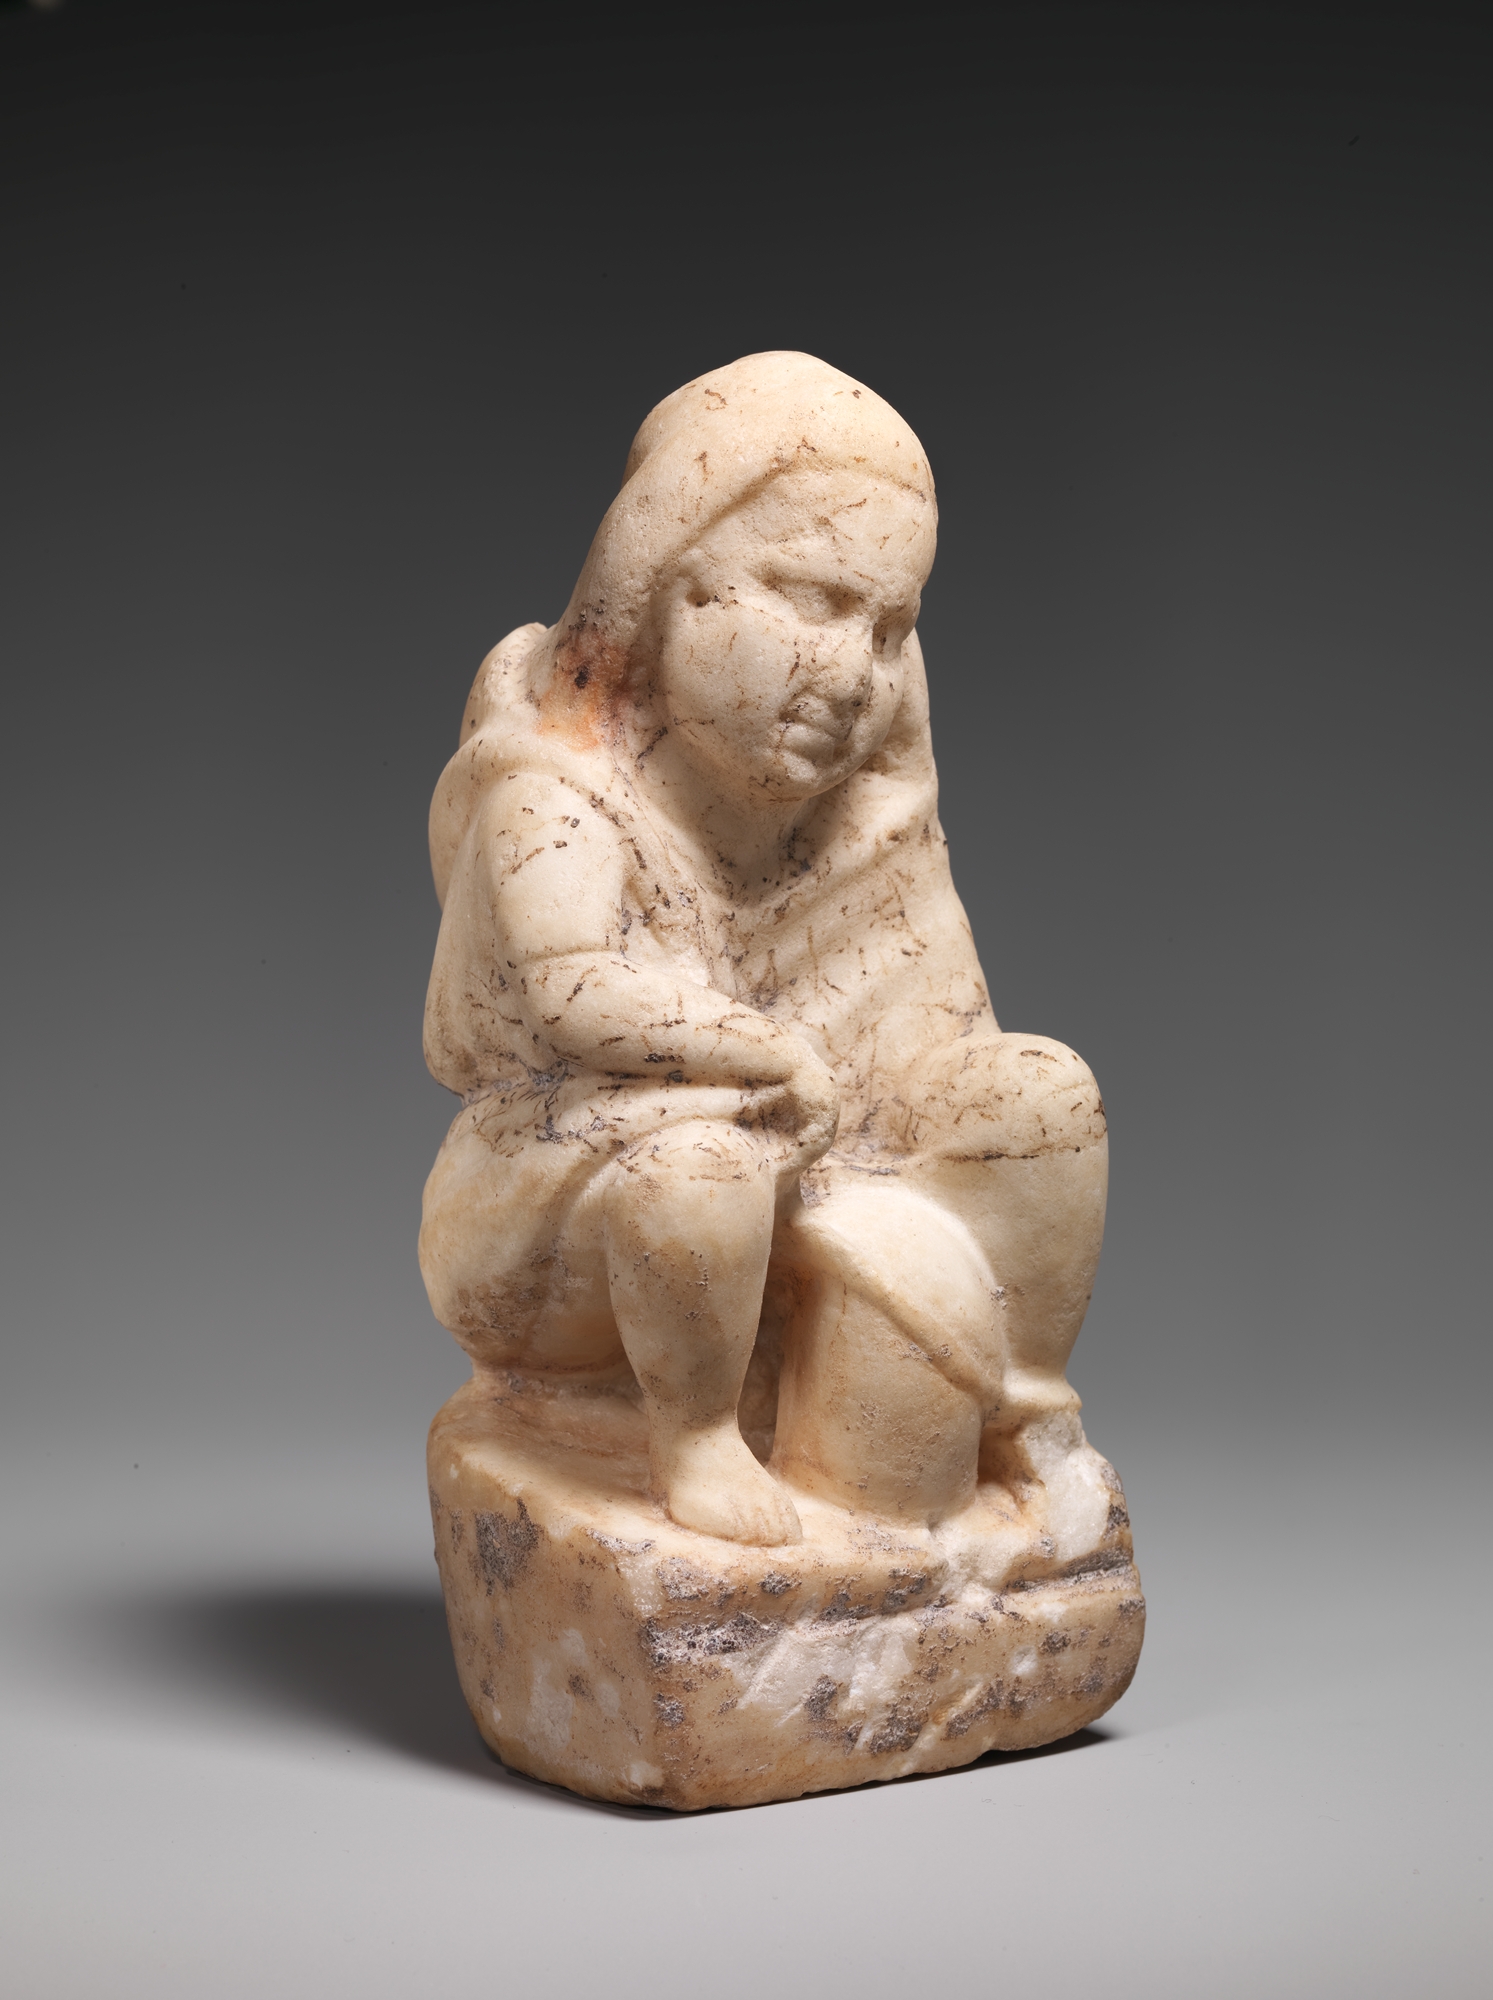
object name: statuette of a slave with lamp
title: Marble statuette of a slave boy with a lantern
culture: roman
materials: marble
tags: boys